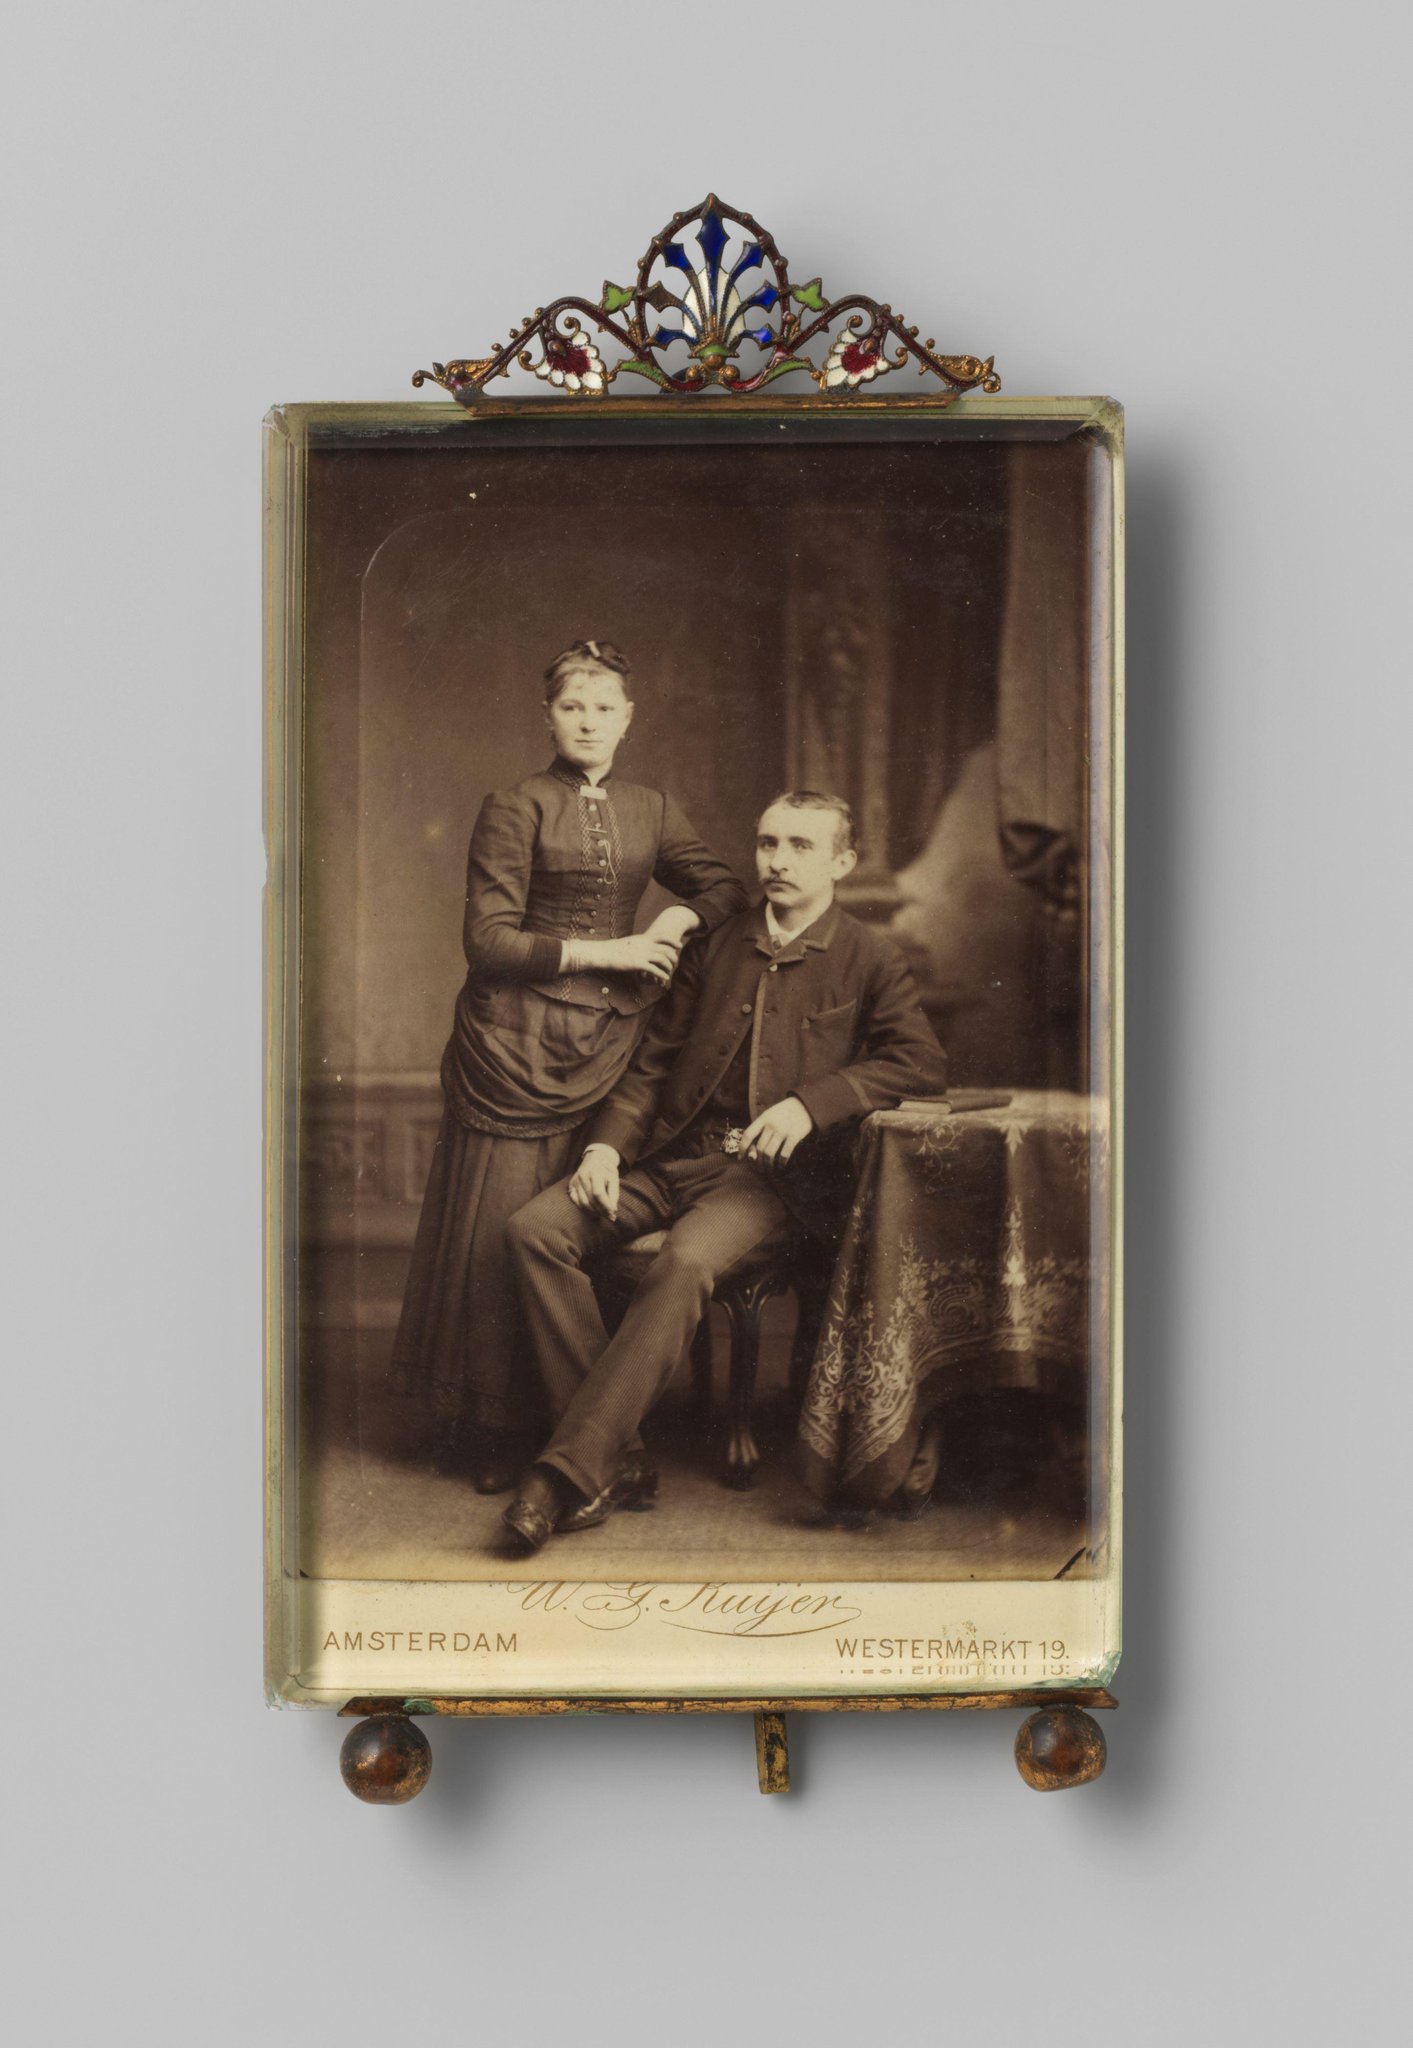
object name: semi enamel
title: Portret van een onbekende man en vrouw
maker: willem gerhardus kuijer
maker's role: fotograaf, hoffotograaf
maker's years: 1834-1899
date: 1880-1906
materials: cardboard, celluloid, glass, metal, paper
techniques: albumen print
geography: amsterdam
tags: adult woman, adult man, anonymous historical person portrayed, couple of lovers, amsterdam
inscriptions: inscription: ‘W.G. Kuijer/ Westermarkt 19./ Amsterdam’